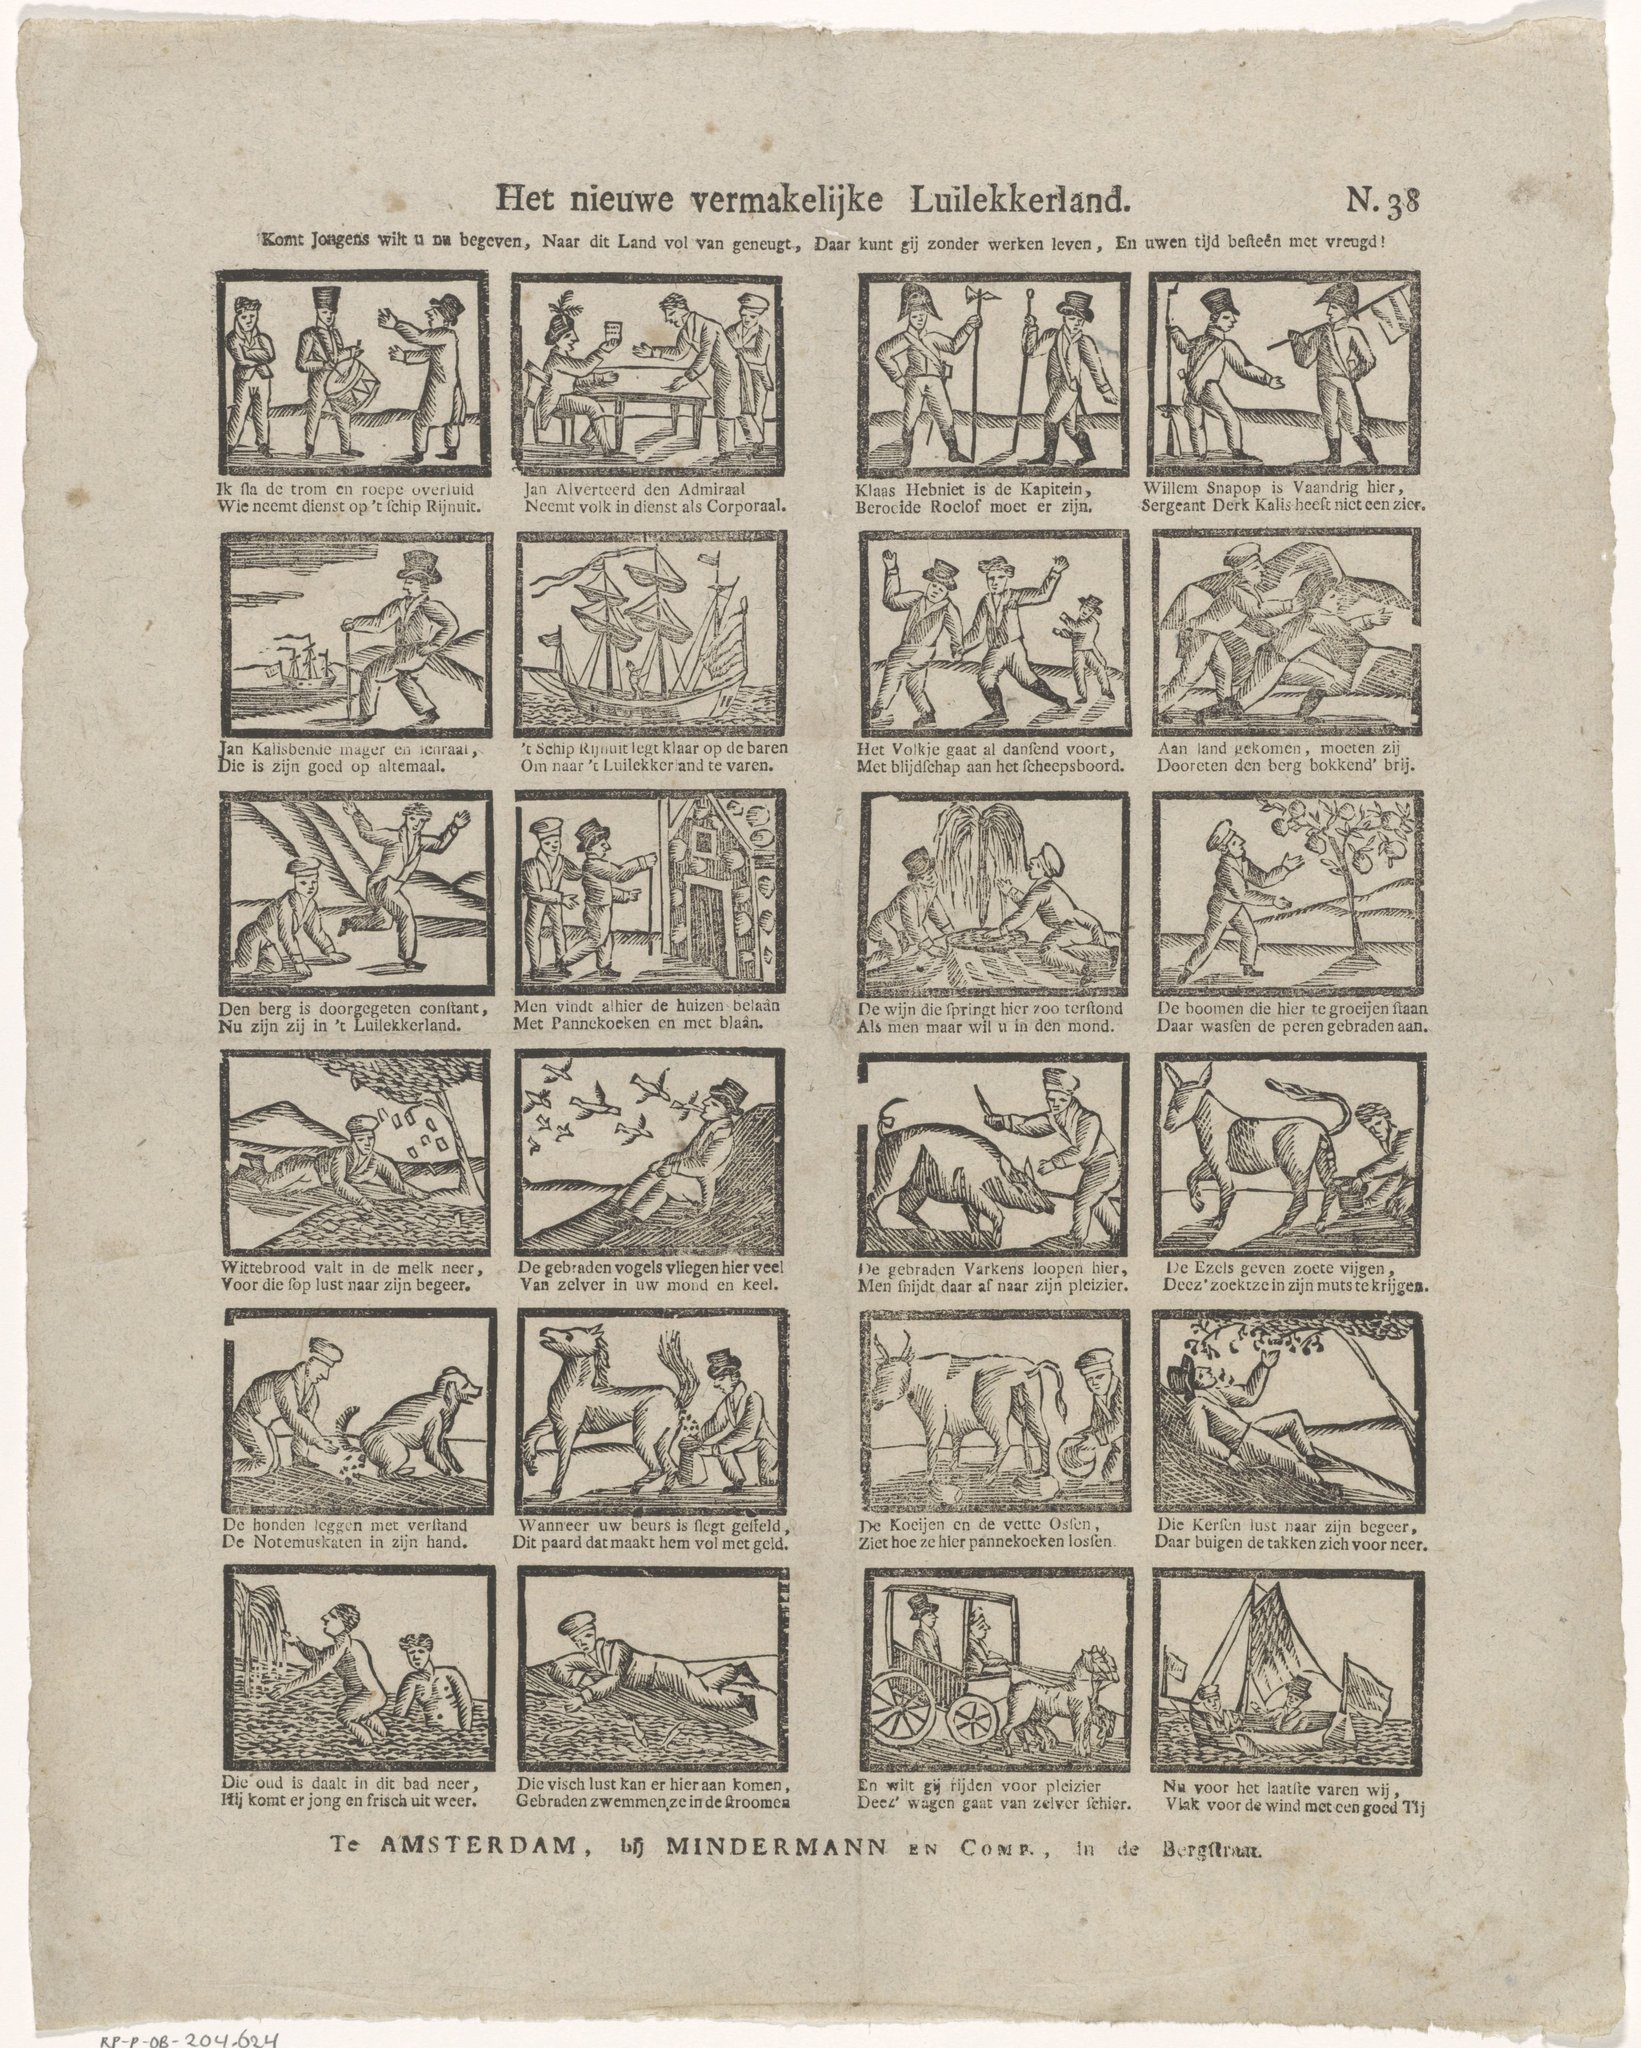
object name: print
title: Het nieuwe vermakelijke Luilekkerland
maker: Anonymous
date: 1822-1848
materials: paper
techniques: letterpress printing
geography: amsterdam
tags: land of cockaigne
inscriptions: collector's mark: Lugt 2760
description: Uitgave van nr. 38 uit de fondslijst van Jan de Lange (II) of Jan Hendrik de Lange met het adres van de wederverkoper Mindermann & Co.